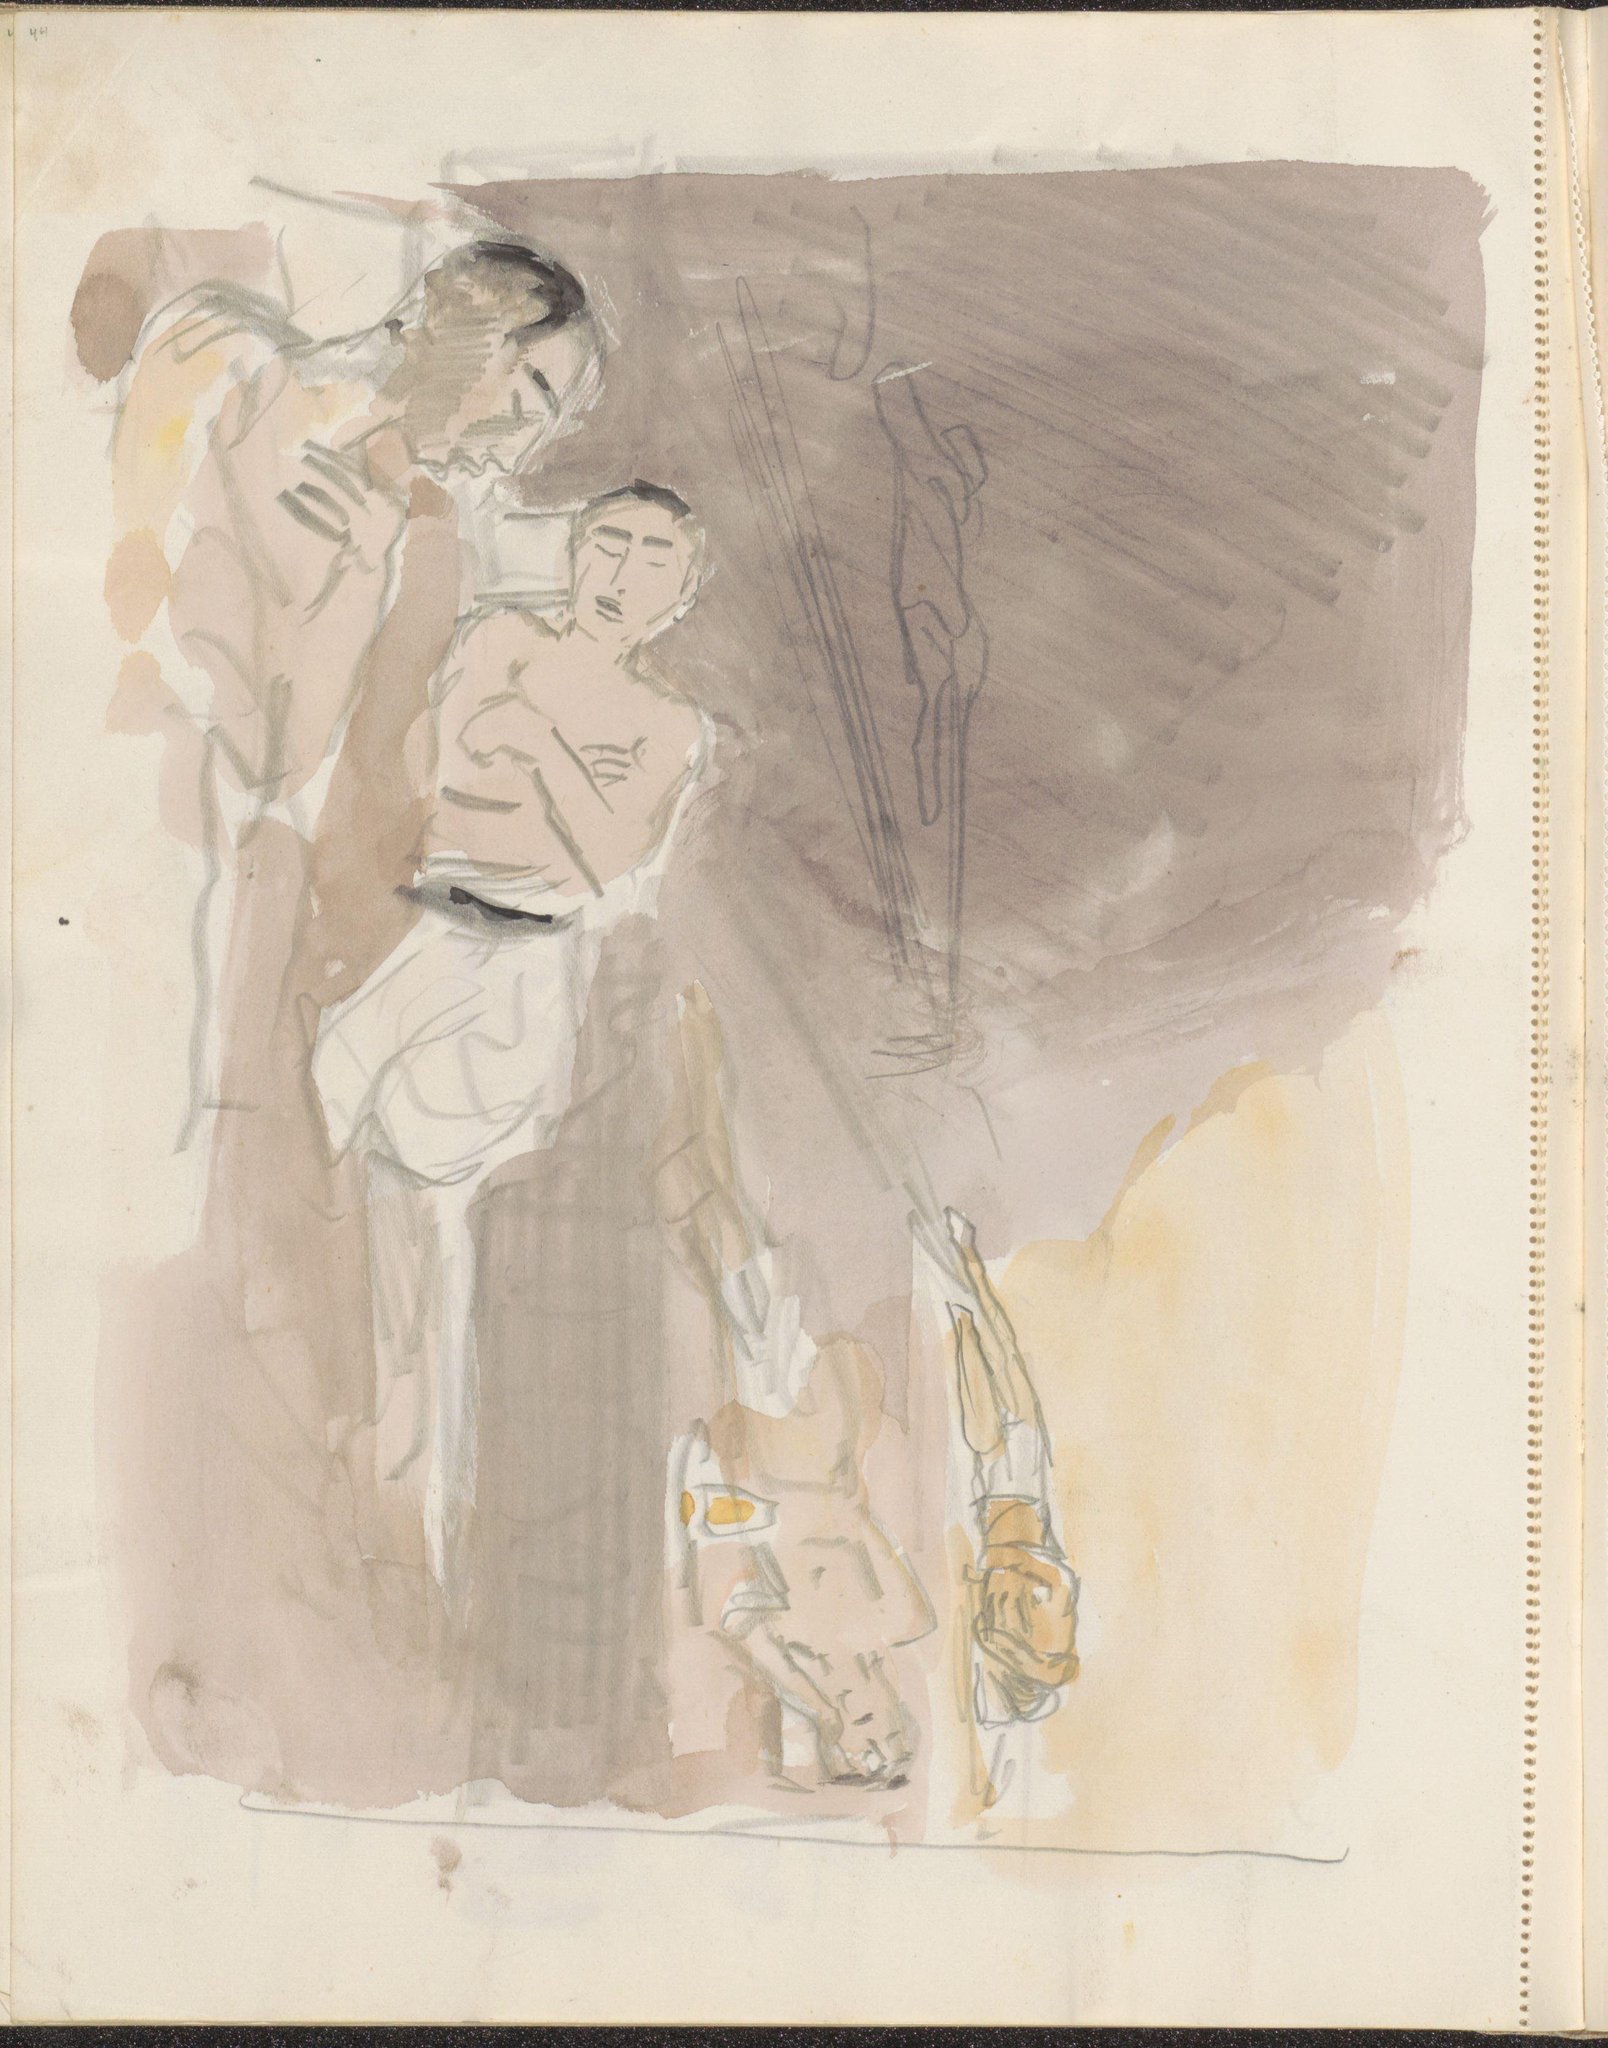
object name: sketchbook leaf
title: Opiumschuivers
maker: marius bauer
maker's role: draughtsman, print maker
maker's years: 1867-1932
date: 1931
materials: paper, pencil, watercolor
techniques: brush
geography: vietnam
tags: opium-house, lying figure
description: Pagina 44 uit een schetsboek met 48 bladen.